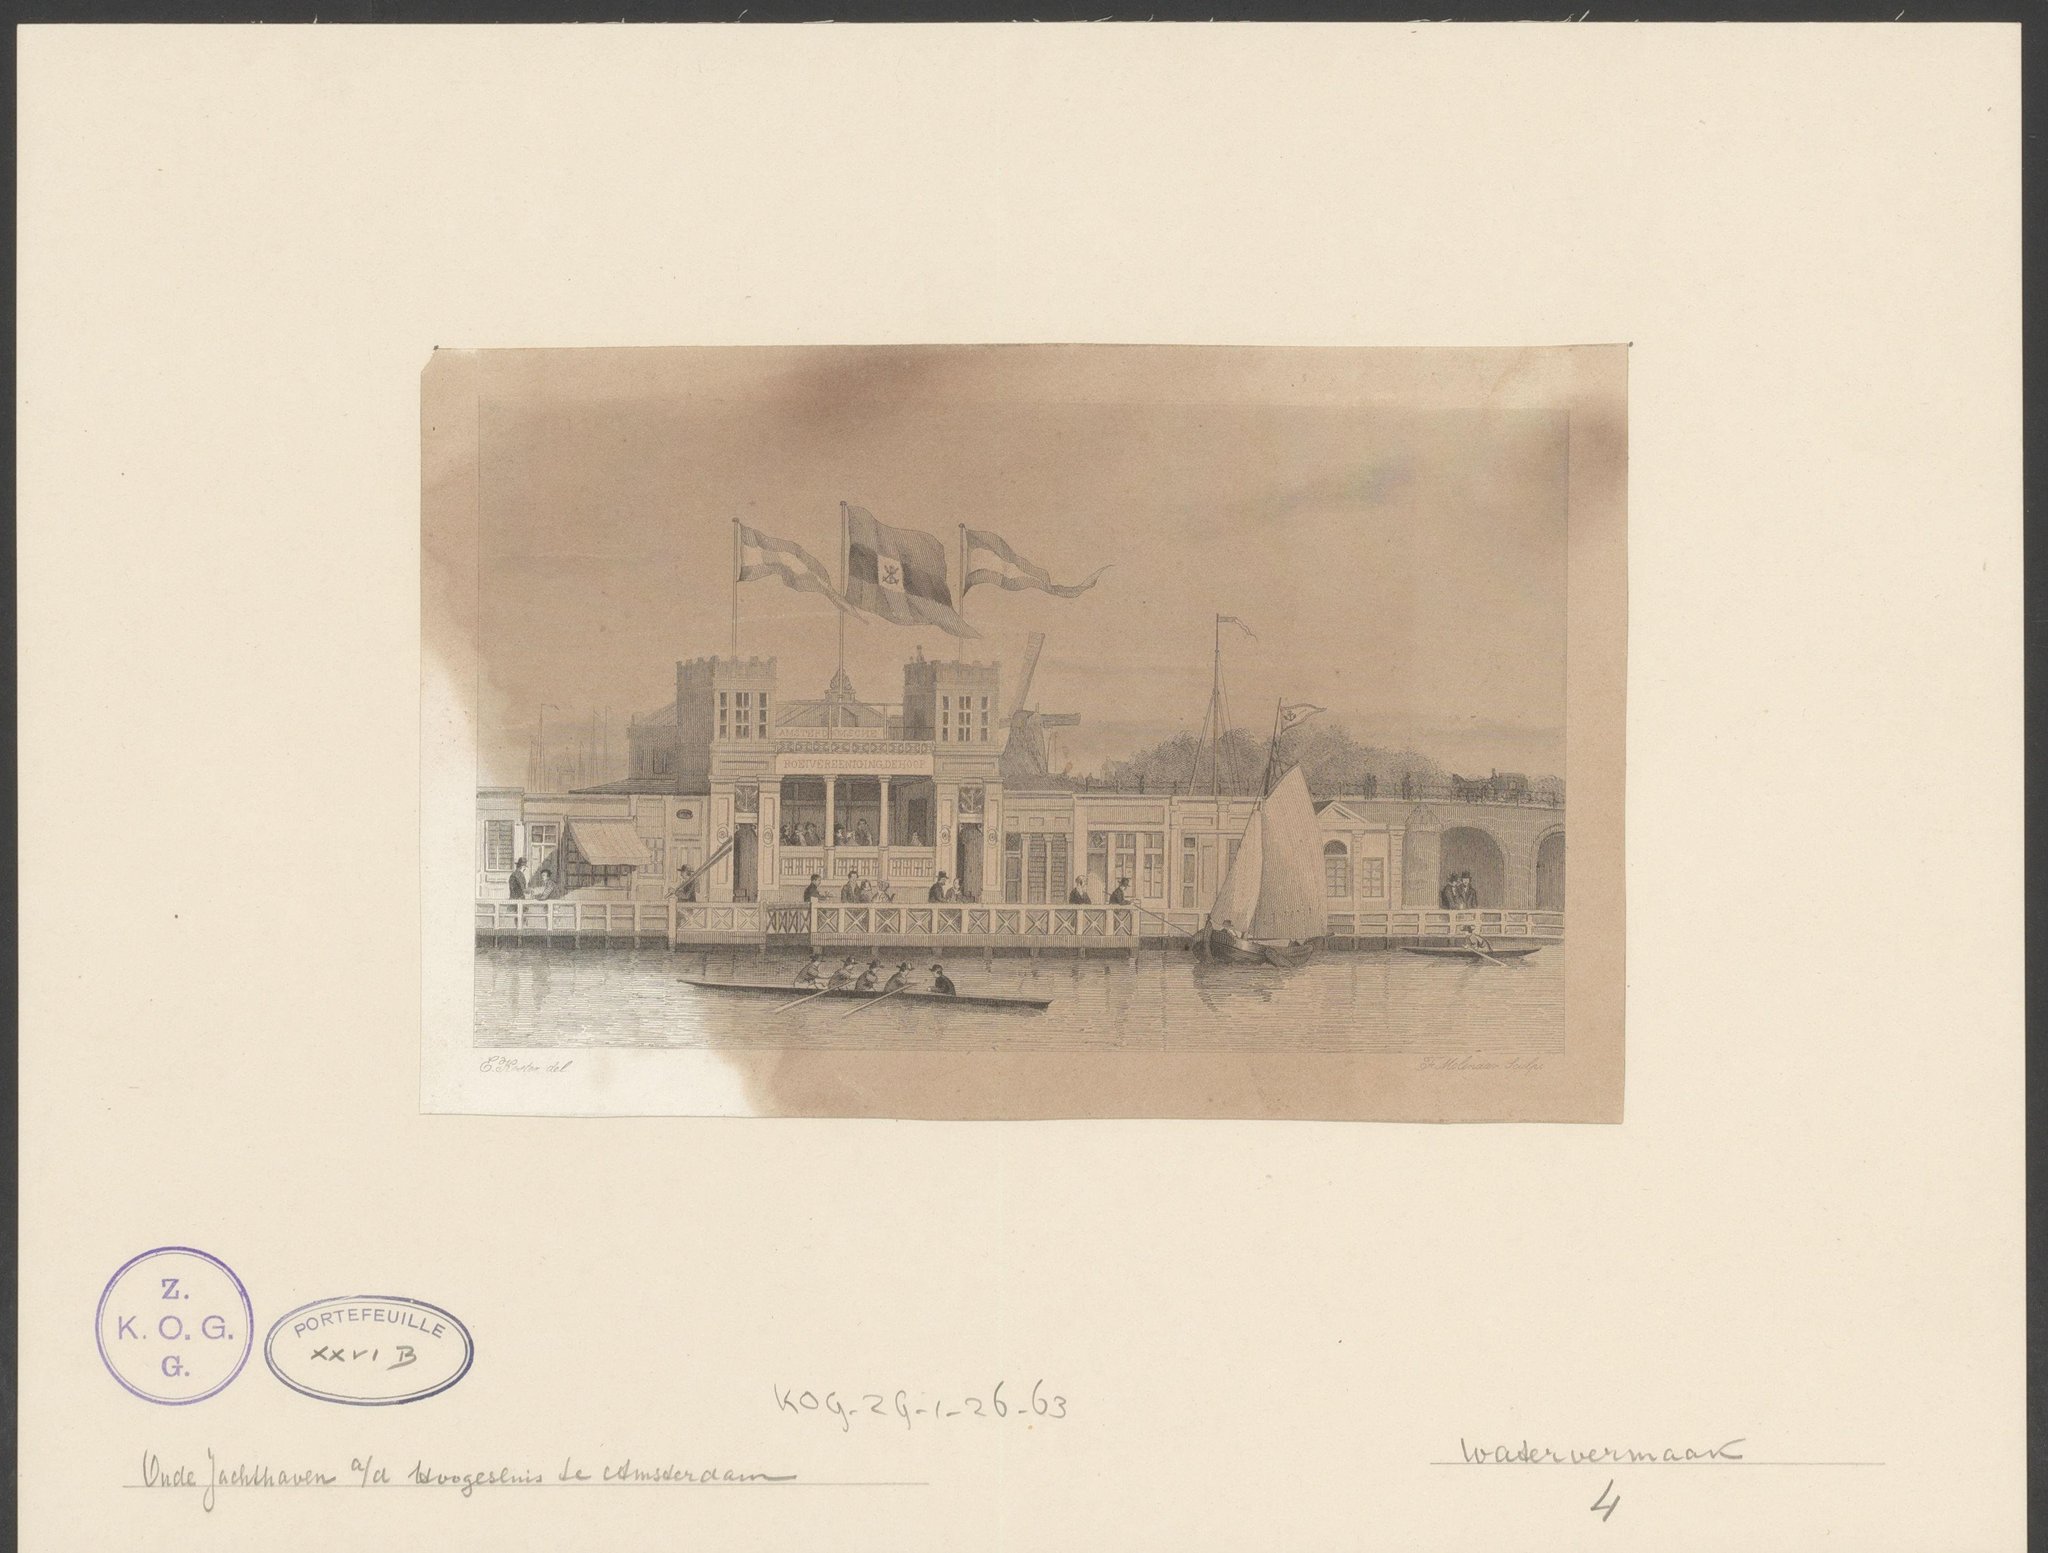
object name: print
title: Clubhuis van roeivereniging De Hoop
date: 1848-1886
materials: paper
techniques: etching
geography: amsterdam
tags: rowing, canoeing, etc. (sport) (+ organization, club (sports, games, etc.)), amsterdam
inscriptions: collector's mark: Lugt 1641, collector's mark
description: Het clubhuis van roeivereniging De Hoop aan de Amstel. De Oude Jachthaven aan de Hogesluis te Amsterdam. Op de voorgrond een roeiboot en een zeilschip. Onderwerpsrubrieken binnen de Atlas Zeden en Gewoonten: Spel en Vermaak; Watervermaak.